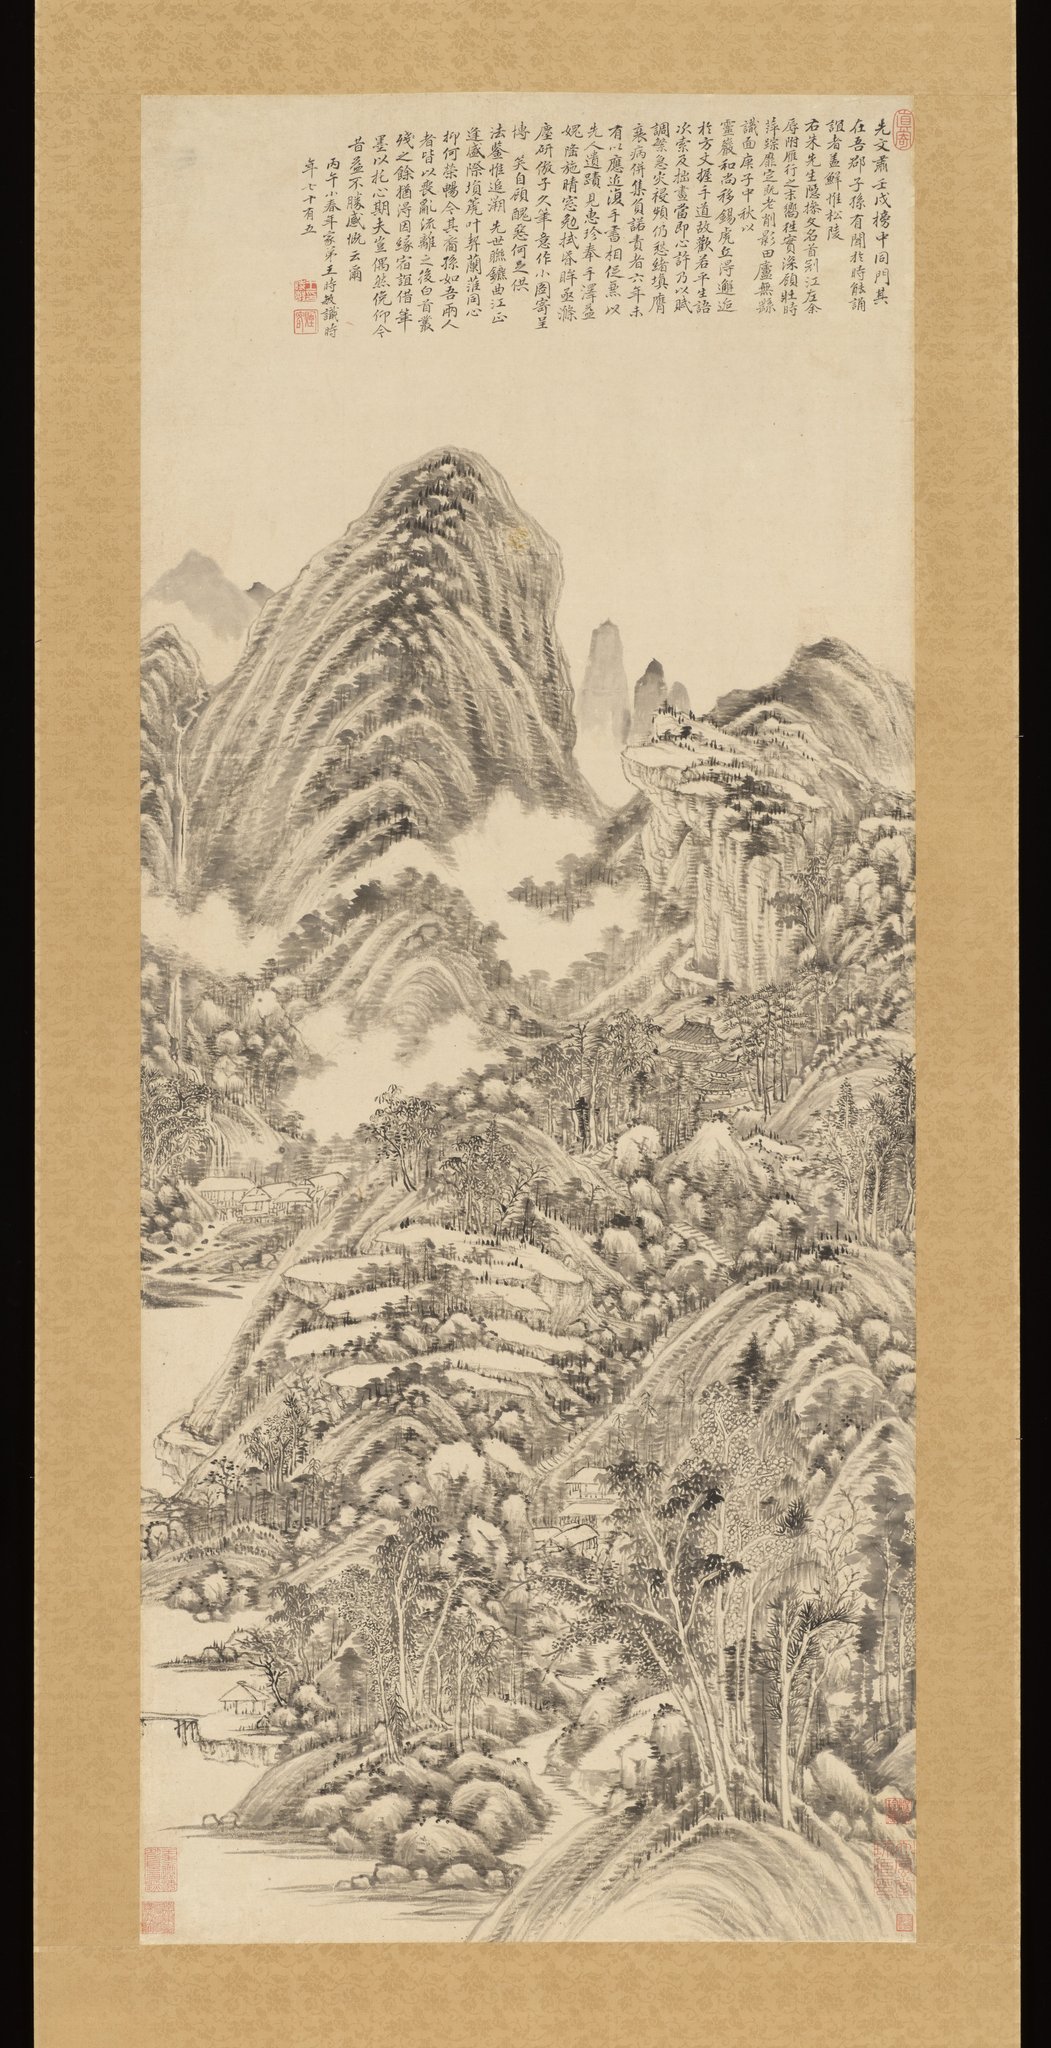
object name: hanging scroll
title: Landscape in the style of Huang Gongwang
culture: chinese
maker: wang shimin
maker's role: artist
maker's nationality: chinese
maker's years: 1592-1680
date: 1666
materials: ink, paper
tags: mountains,landscapes